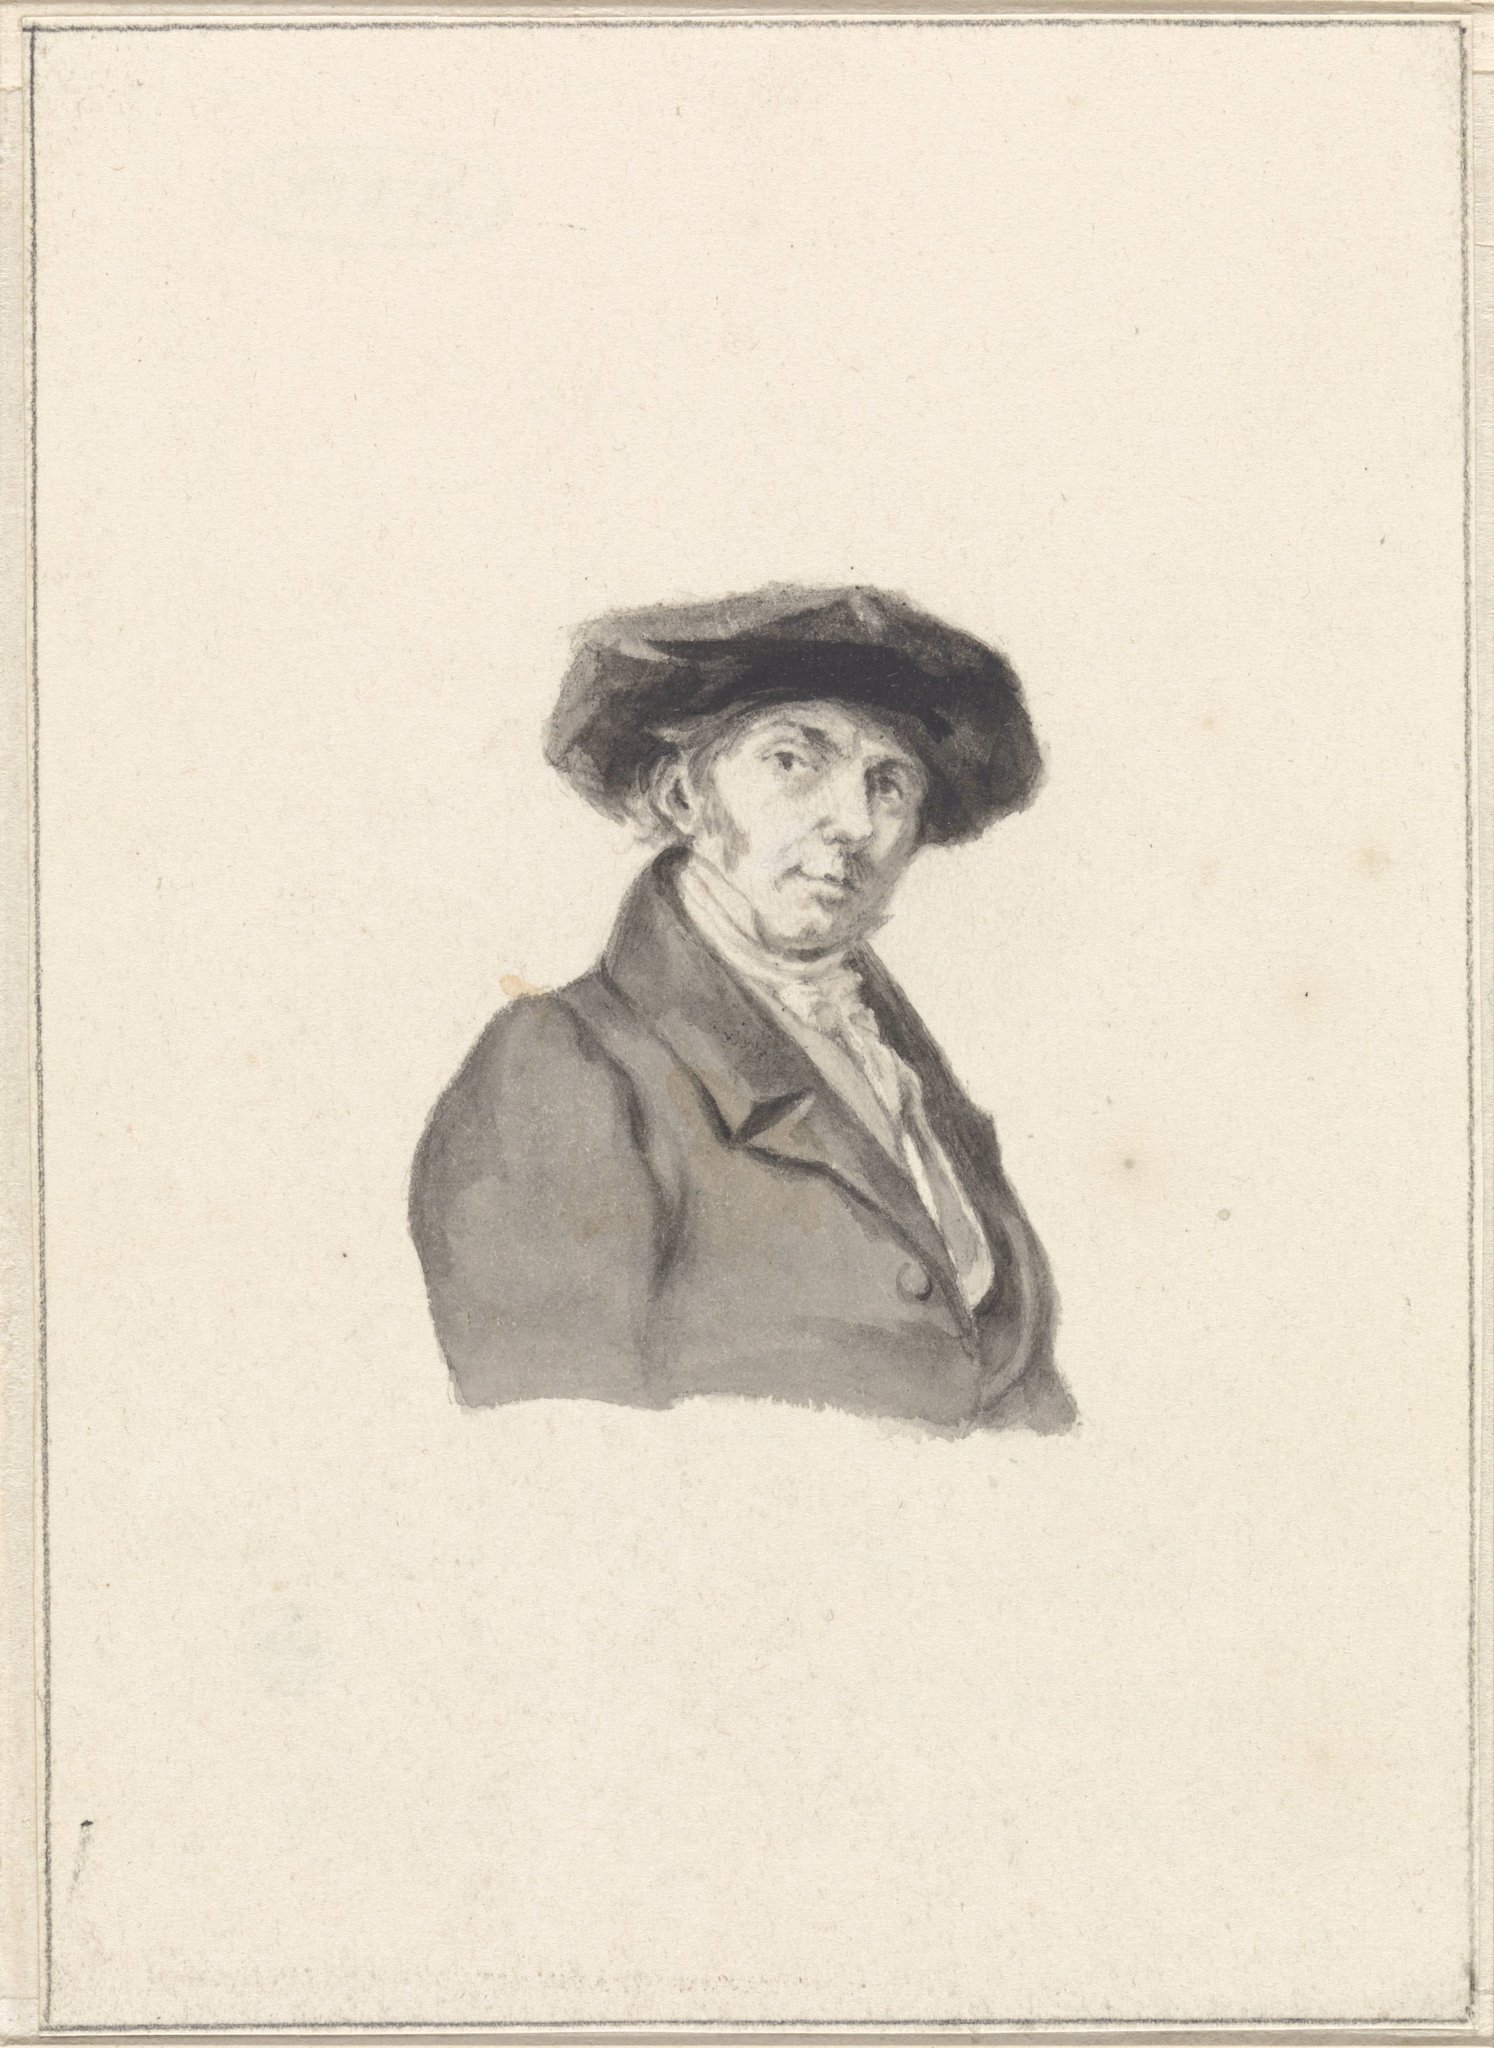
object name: watercolor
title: Portret van Andreas Danekes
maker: Anonymous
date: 1800-1850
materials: paper, watercolor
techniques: brush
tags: amsterdam, painter, andreas danekes, historical persons, portrait, self-portrait of painter, portrait, self-portrait of artist, portrait, self-portrait of draughtsman